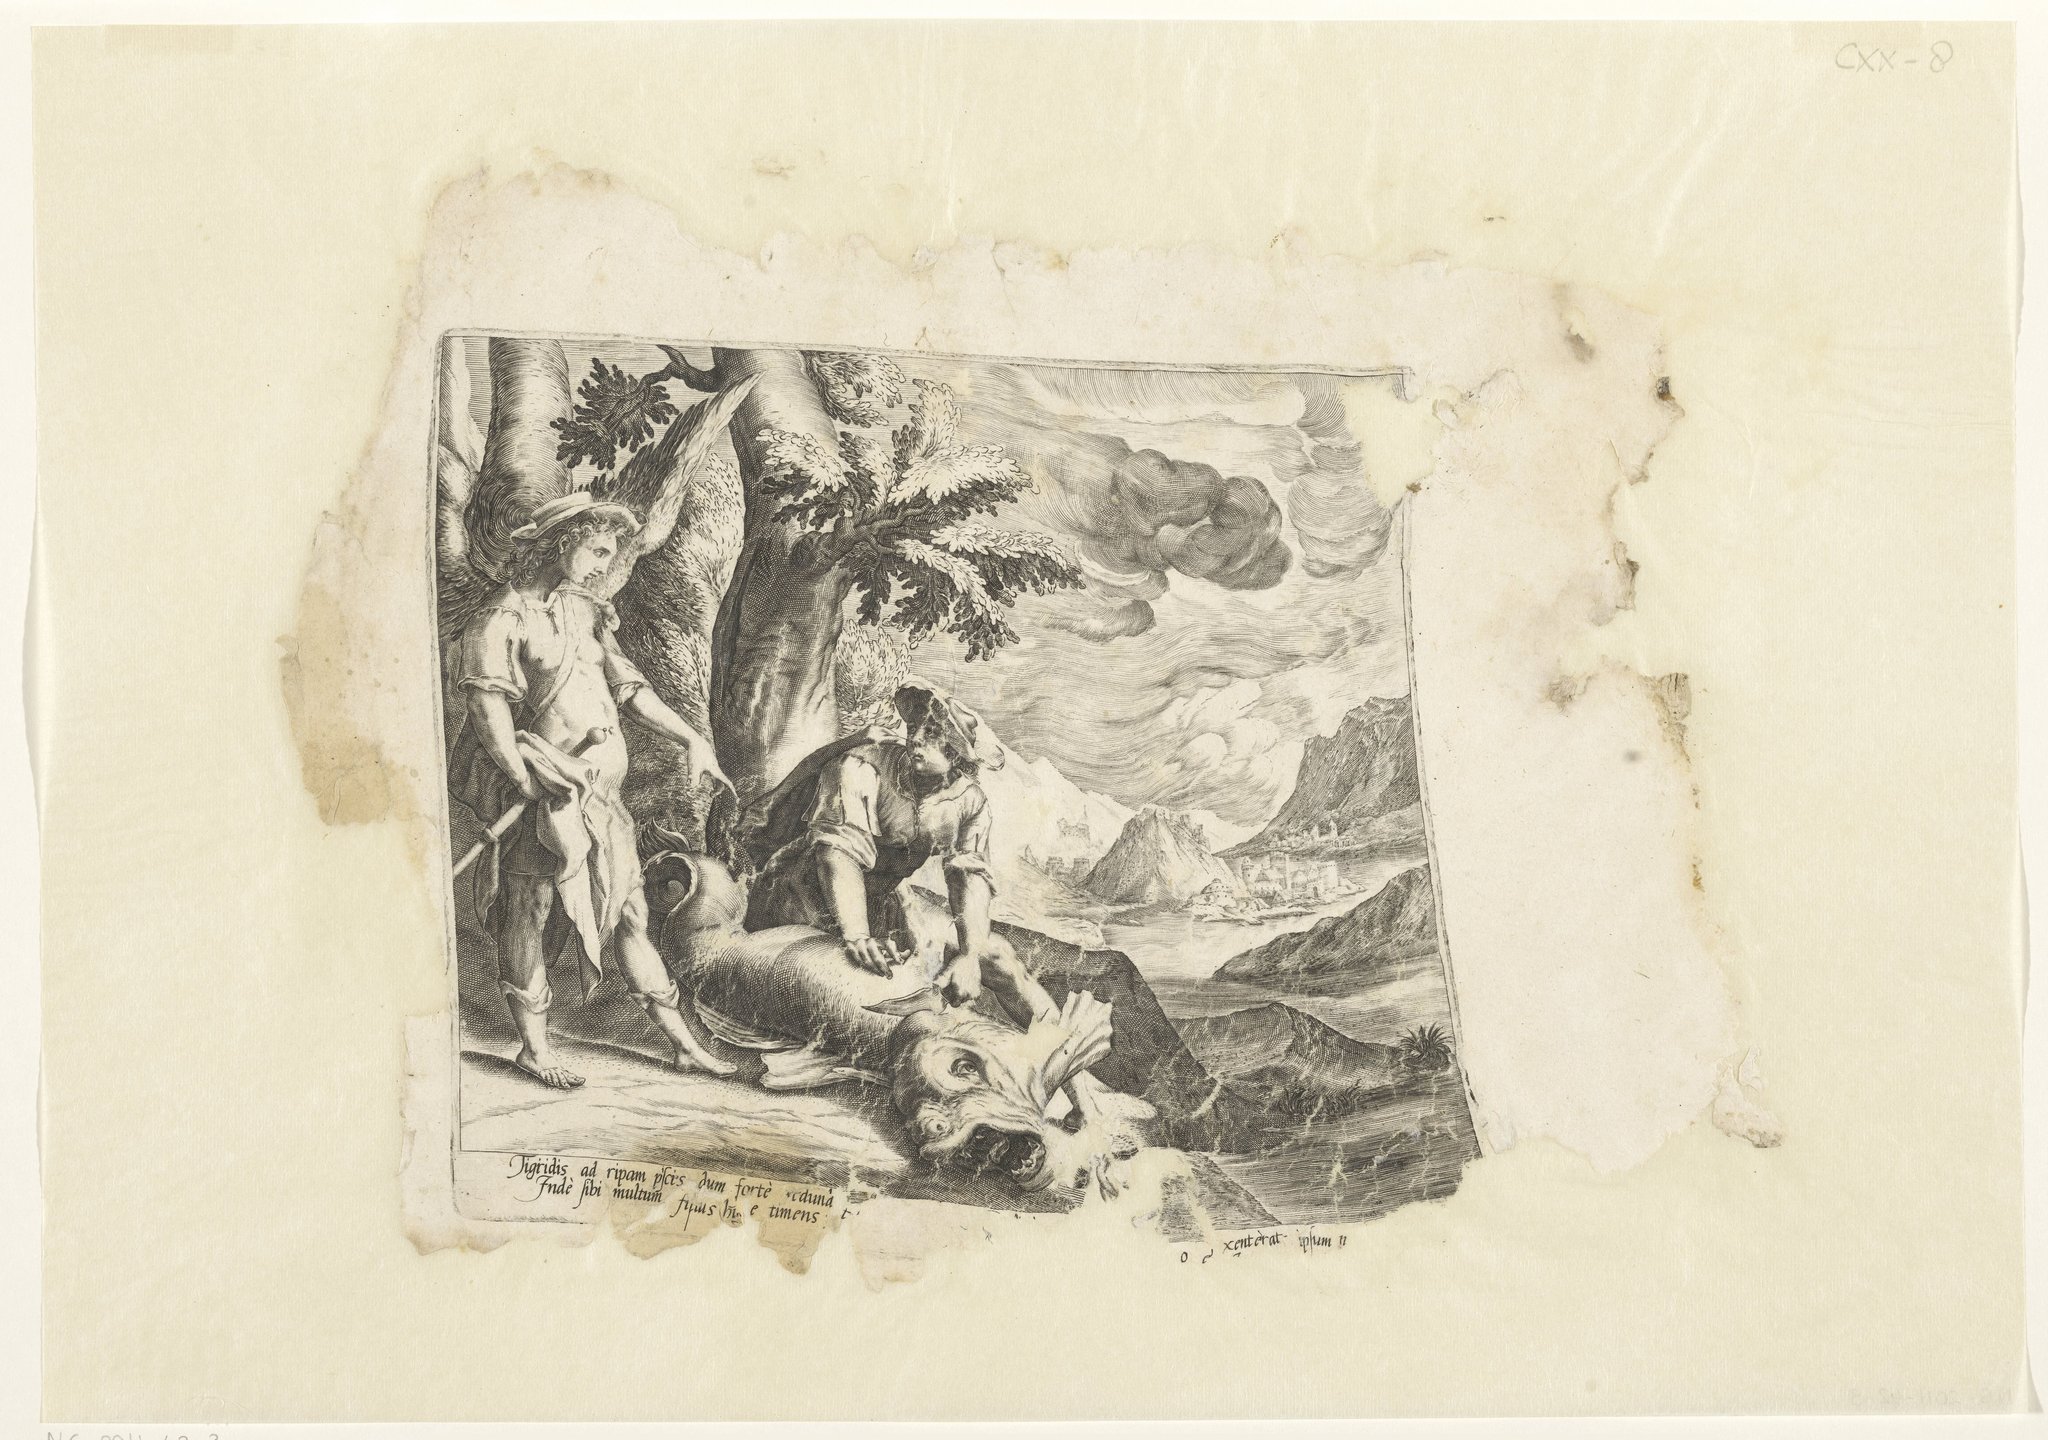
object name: print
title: Visvangst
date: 1580-1596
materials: paper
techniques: engraving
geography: amsterdam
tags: the angel raphael tells tobias to cut the fish to pieces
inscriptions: watermark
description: De prenten in de Nova Zembla collectie zijn tijdens een expeditie van Willem Barendsz en Jacob van Heemskerk in 1596-1597 noodgedwongen in het winterkamp, het ‘Behouden Huis’, op het eiland achtergelaten. De prenten waren in één of meerdere stapels als handelswaar meegenomen vanuit Amsterdam. Bijna drie eeuwen later, in 1871, keerde de Noor Elling Carlsen terug naar Nova Zembla en vond daar de restanten van het ‘Behouden Huis, inclusief een groot deel van de inventaris. Een deel van de prenten, in de vorm van aaneengekoekte kluiten, werd toen ook teruggevonden. De papierkluiten waren soms op meerdere plekken gebroken. Tussen 1975-1979 zijn de prenten van elkaar gescheiden. Dit leverde in totaal ca. 1000 fragmenten van ca. 400 afdrukken van ca. 150 verschillende prenten op. Voor zover mogelijk zijn de fragmenten samengevoegd en zijn de prenten gereconstrueerd.